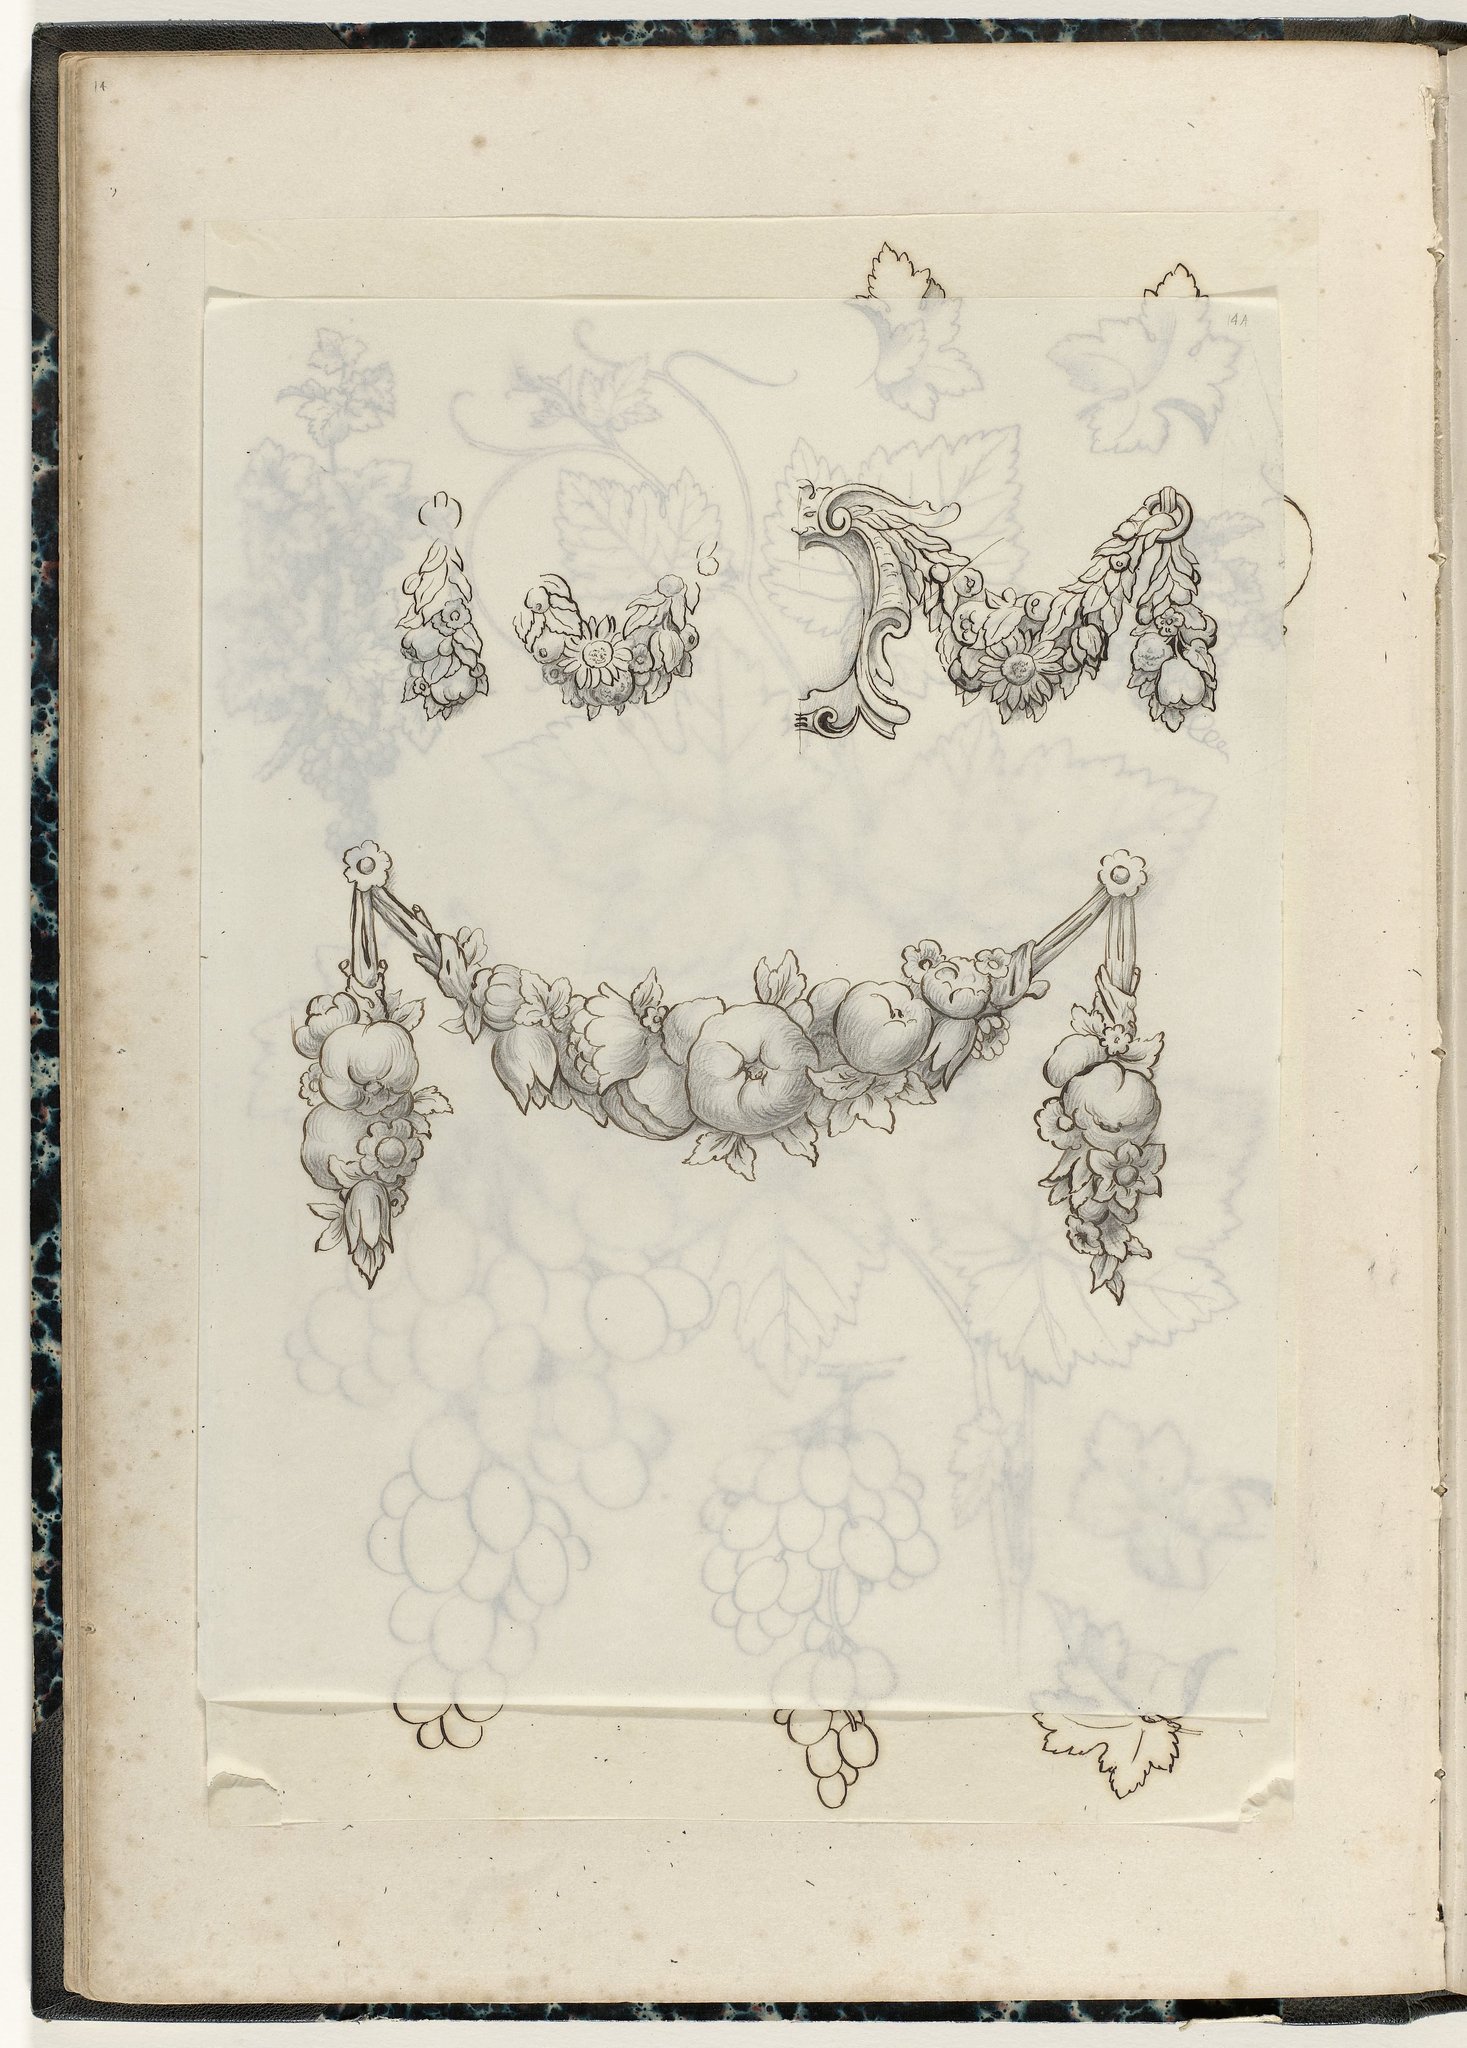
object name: drawing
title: Vier festoenen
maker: Anonymous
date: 1866-1900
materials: ink, pencil, paper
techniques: drawing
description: Onderaan hangt een groot festoen, daarboven drie kleinere. Het festoen rechtsboven is bevestigd aan een half afgebeelde cartouche.